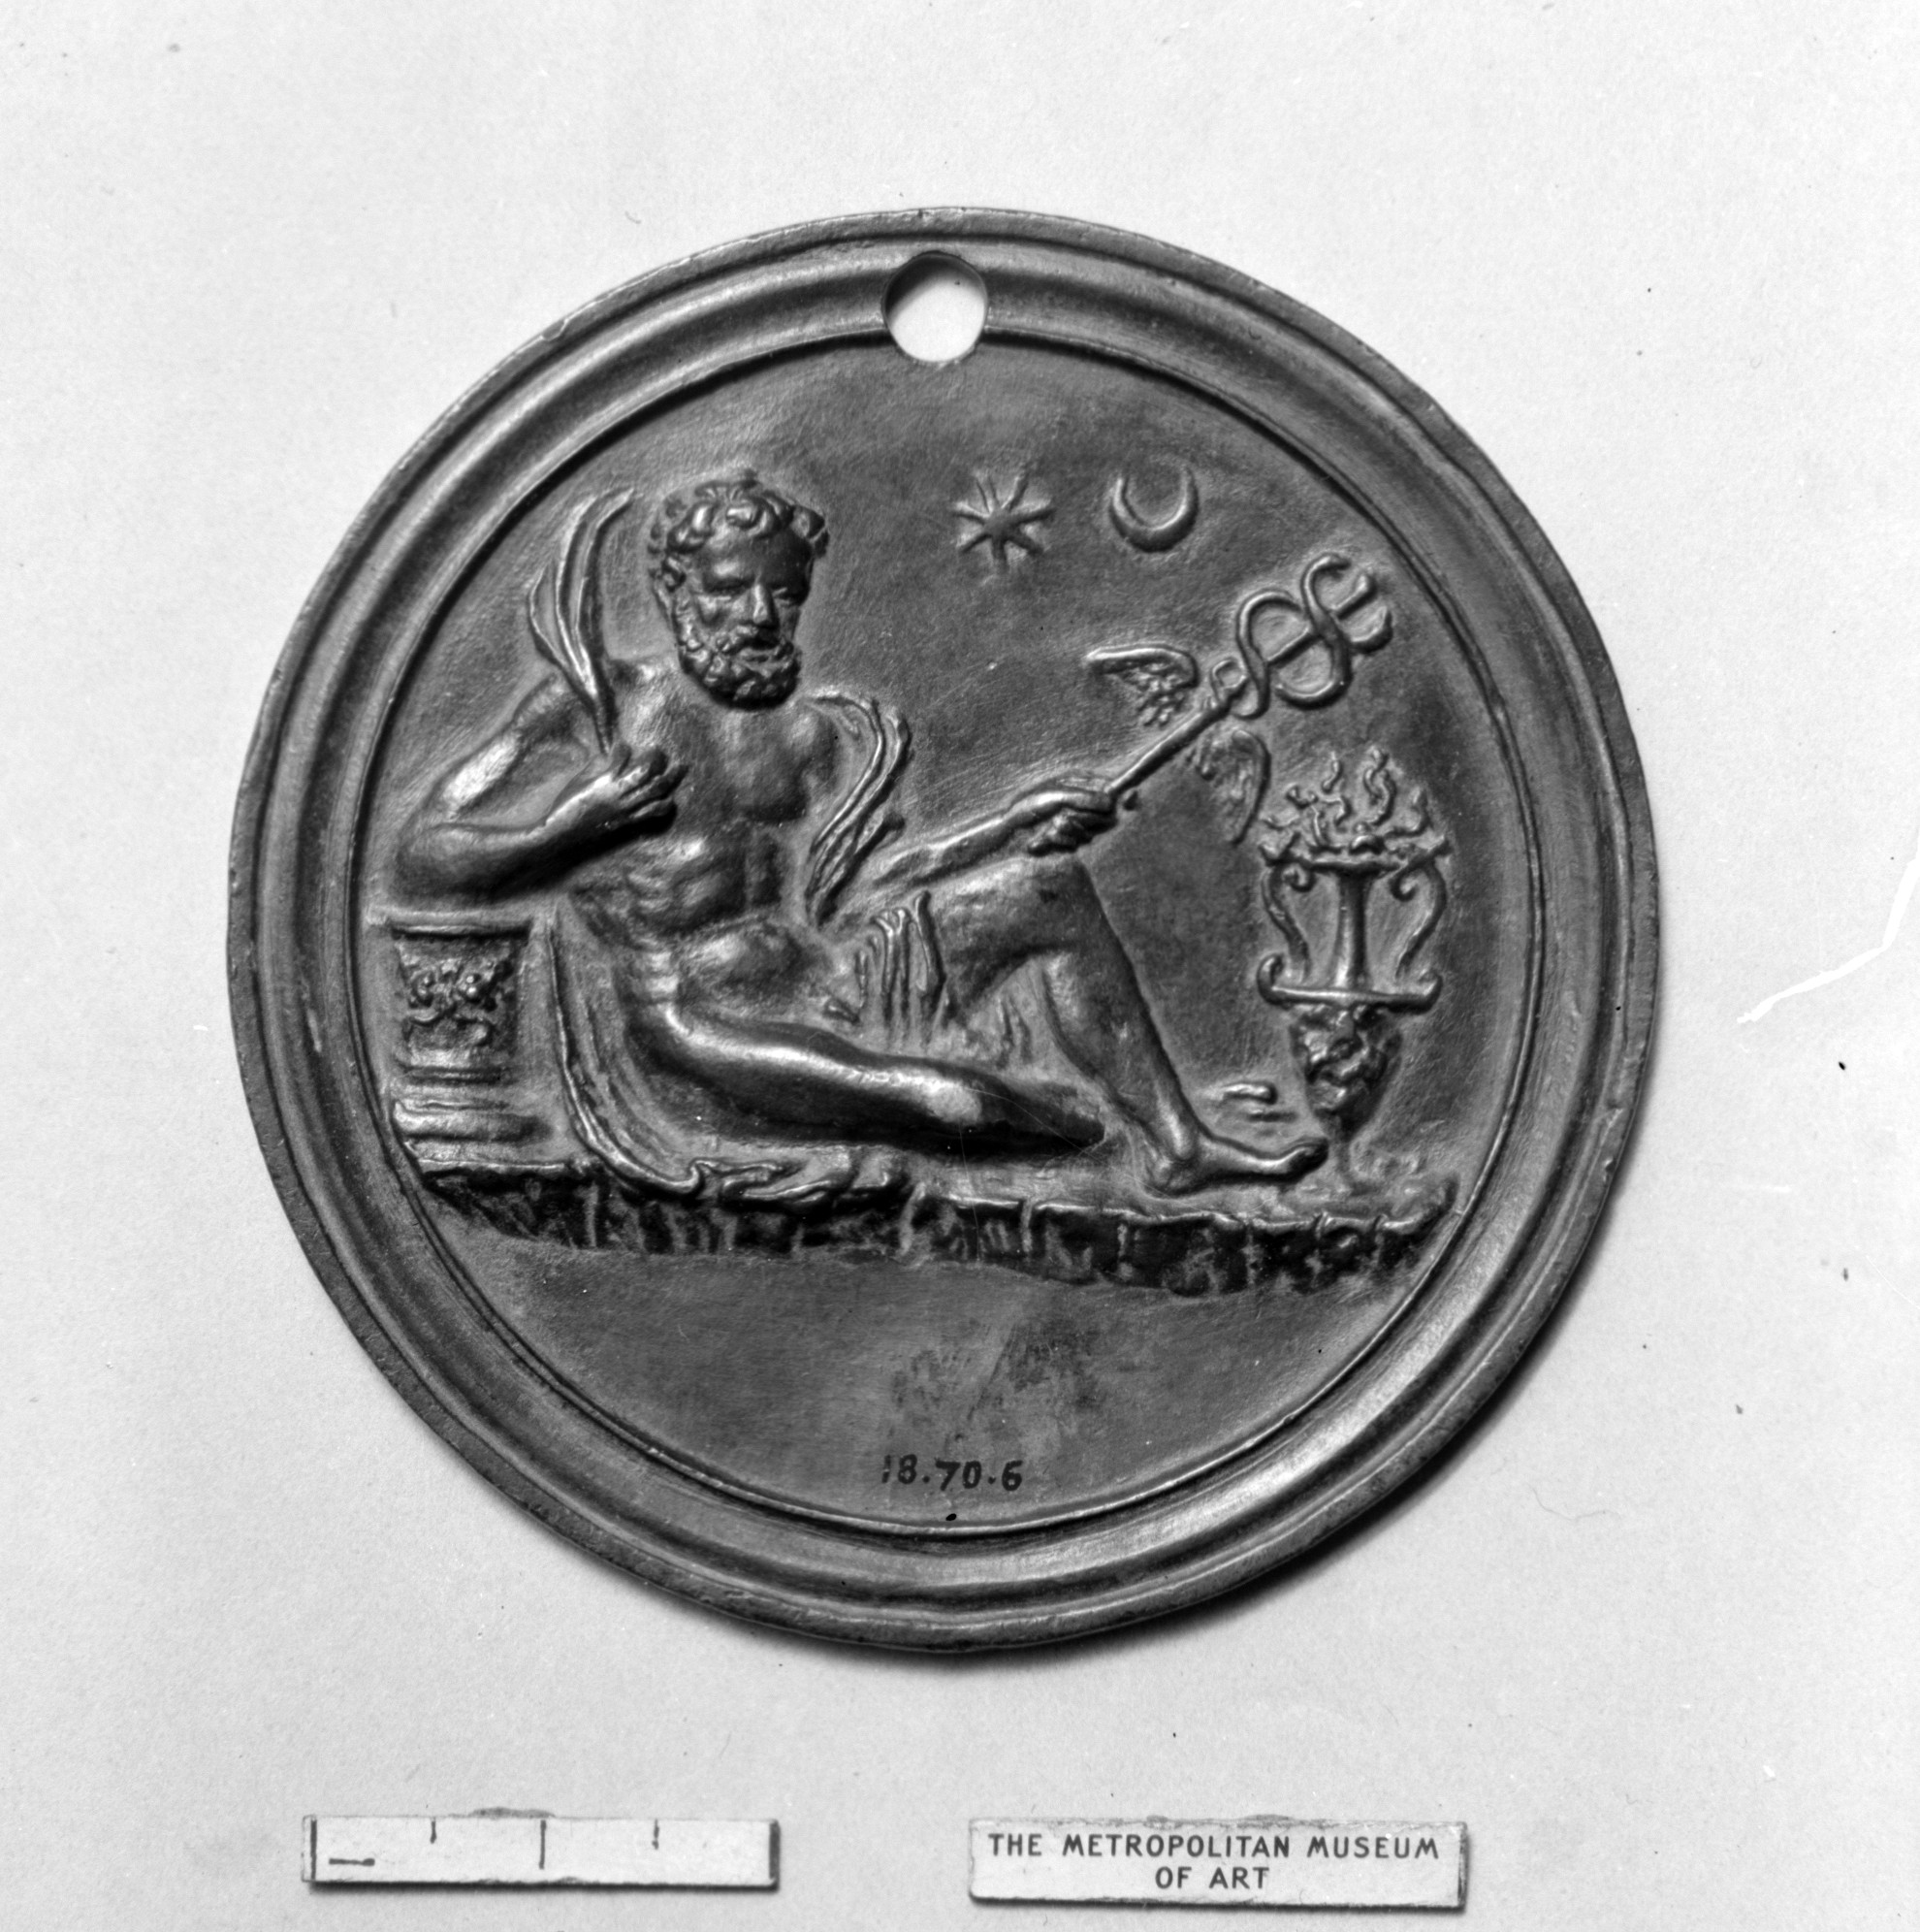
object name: plaquette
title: Mercury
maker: master of the roman charity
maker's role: maker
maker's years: 1475-1575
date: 1501-1533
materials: bronze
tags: mercury